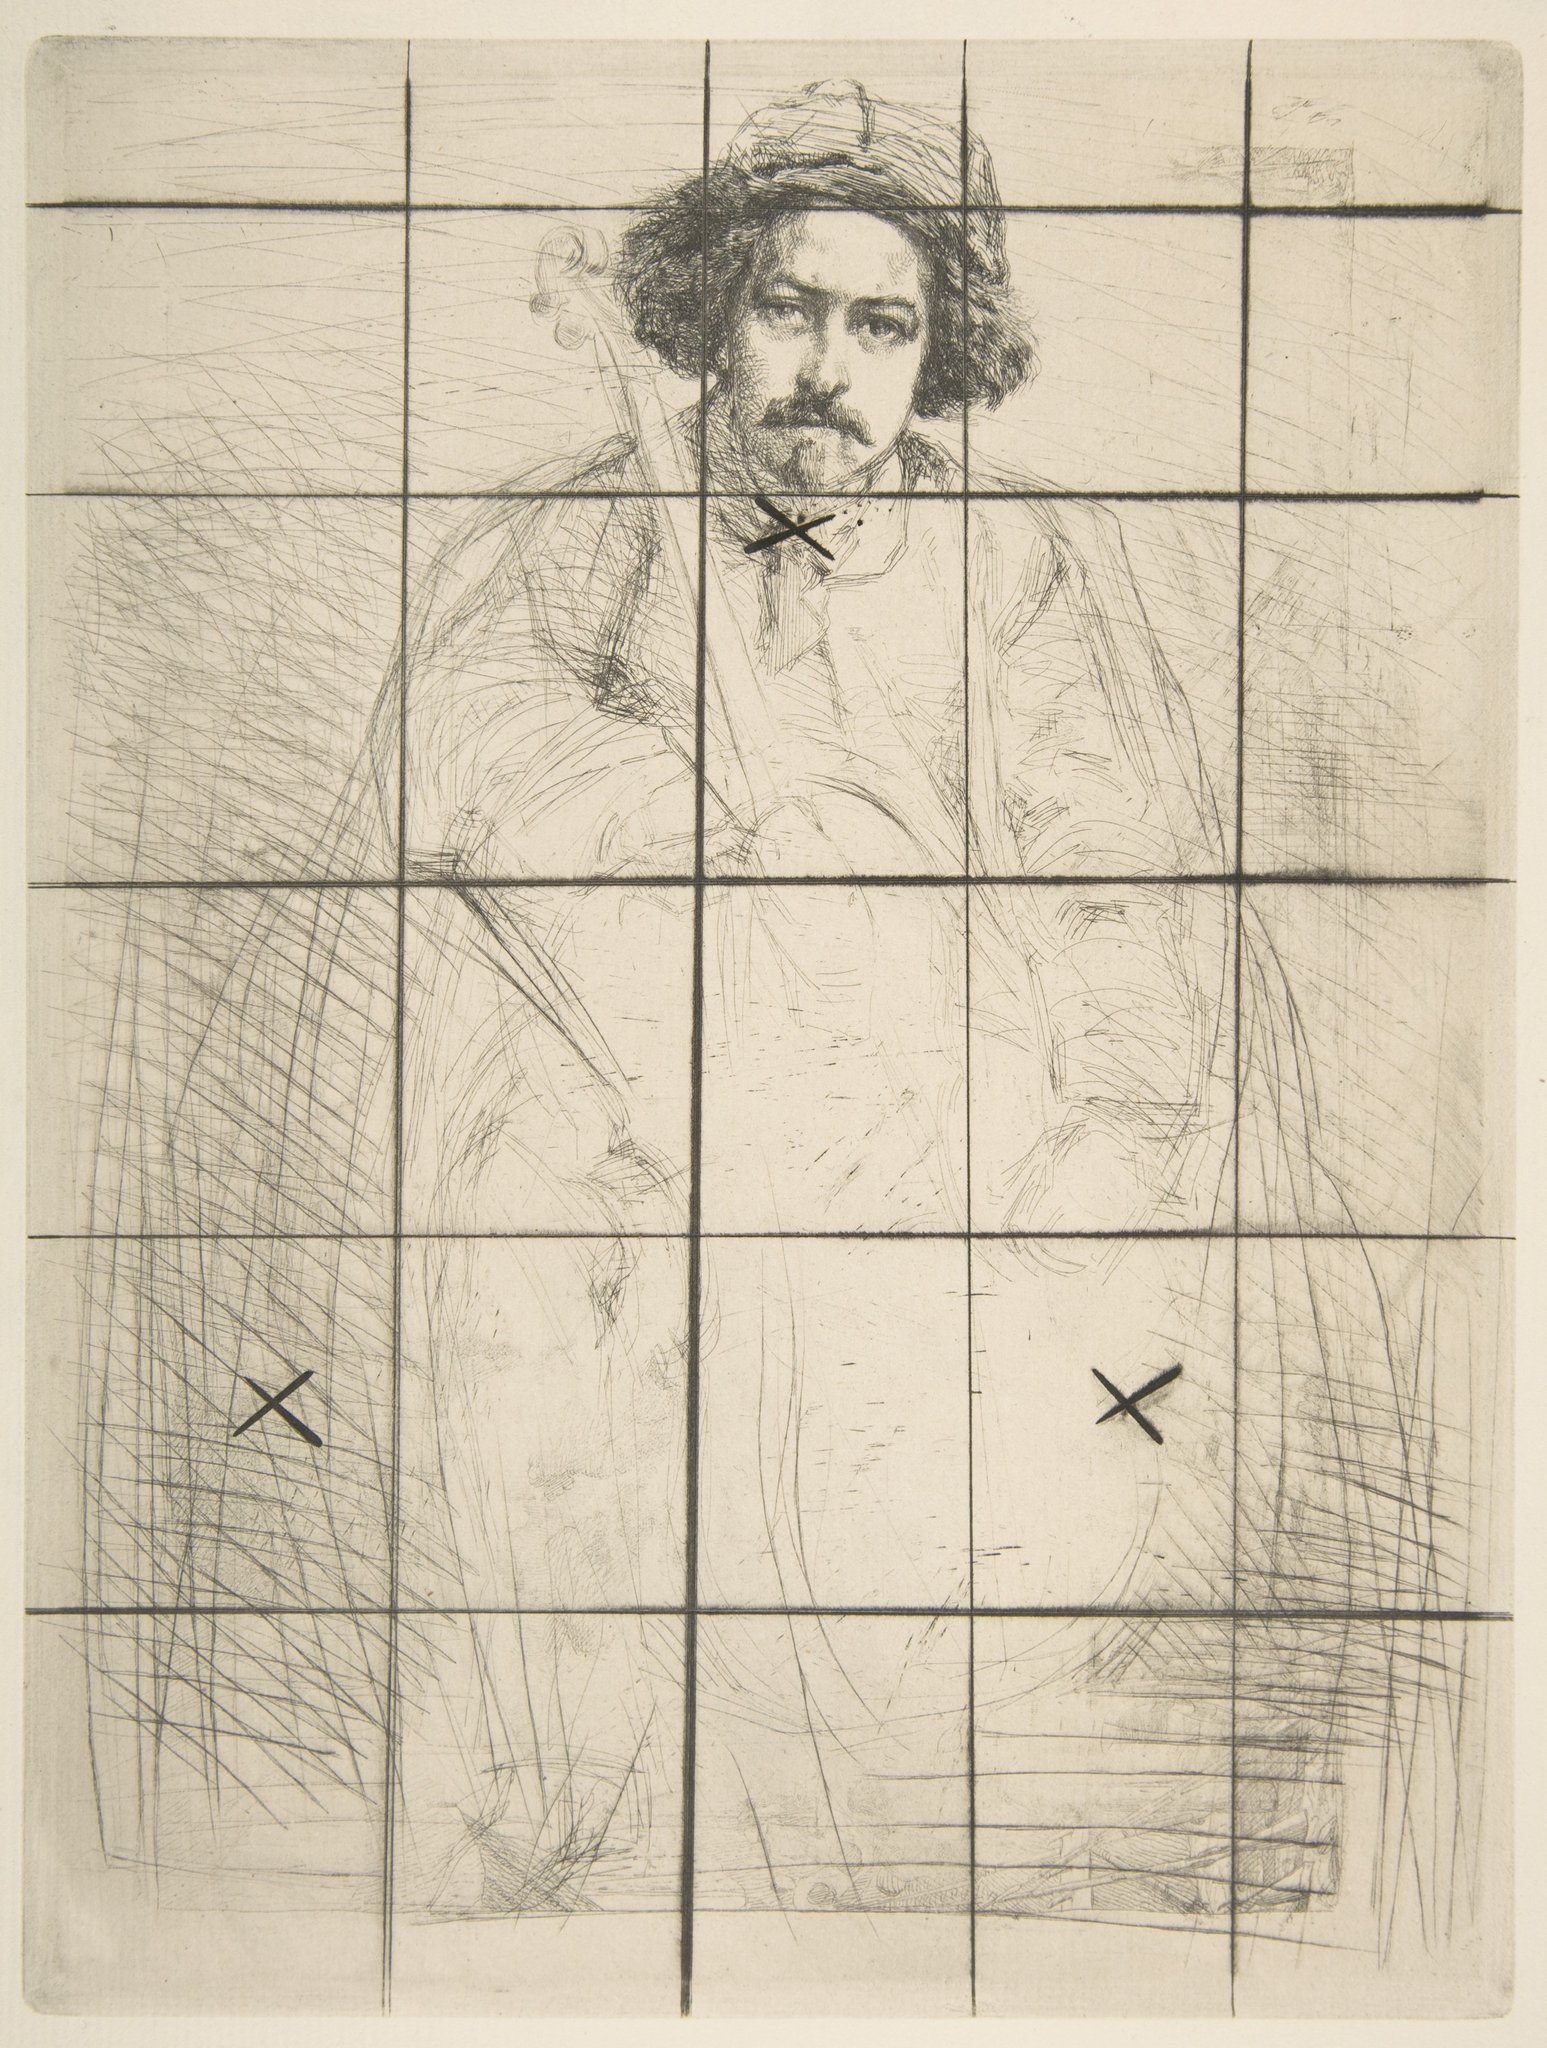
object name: print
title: Becquet (J. Becquet, Sculptor)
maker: james mcneill whistler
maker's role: artist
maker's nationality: american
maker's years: 1834-1903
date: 1859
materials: paper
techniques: etching, printing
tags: men